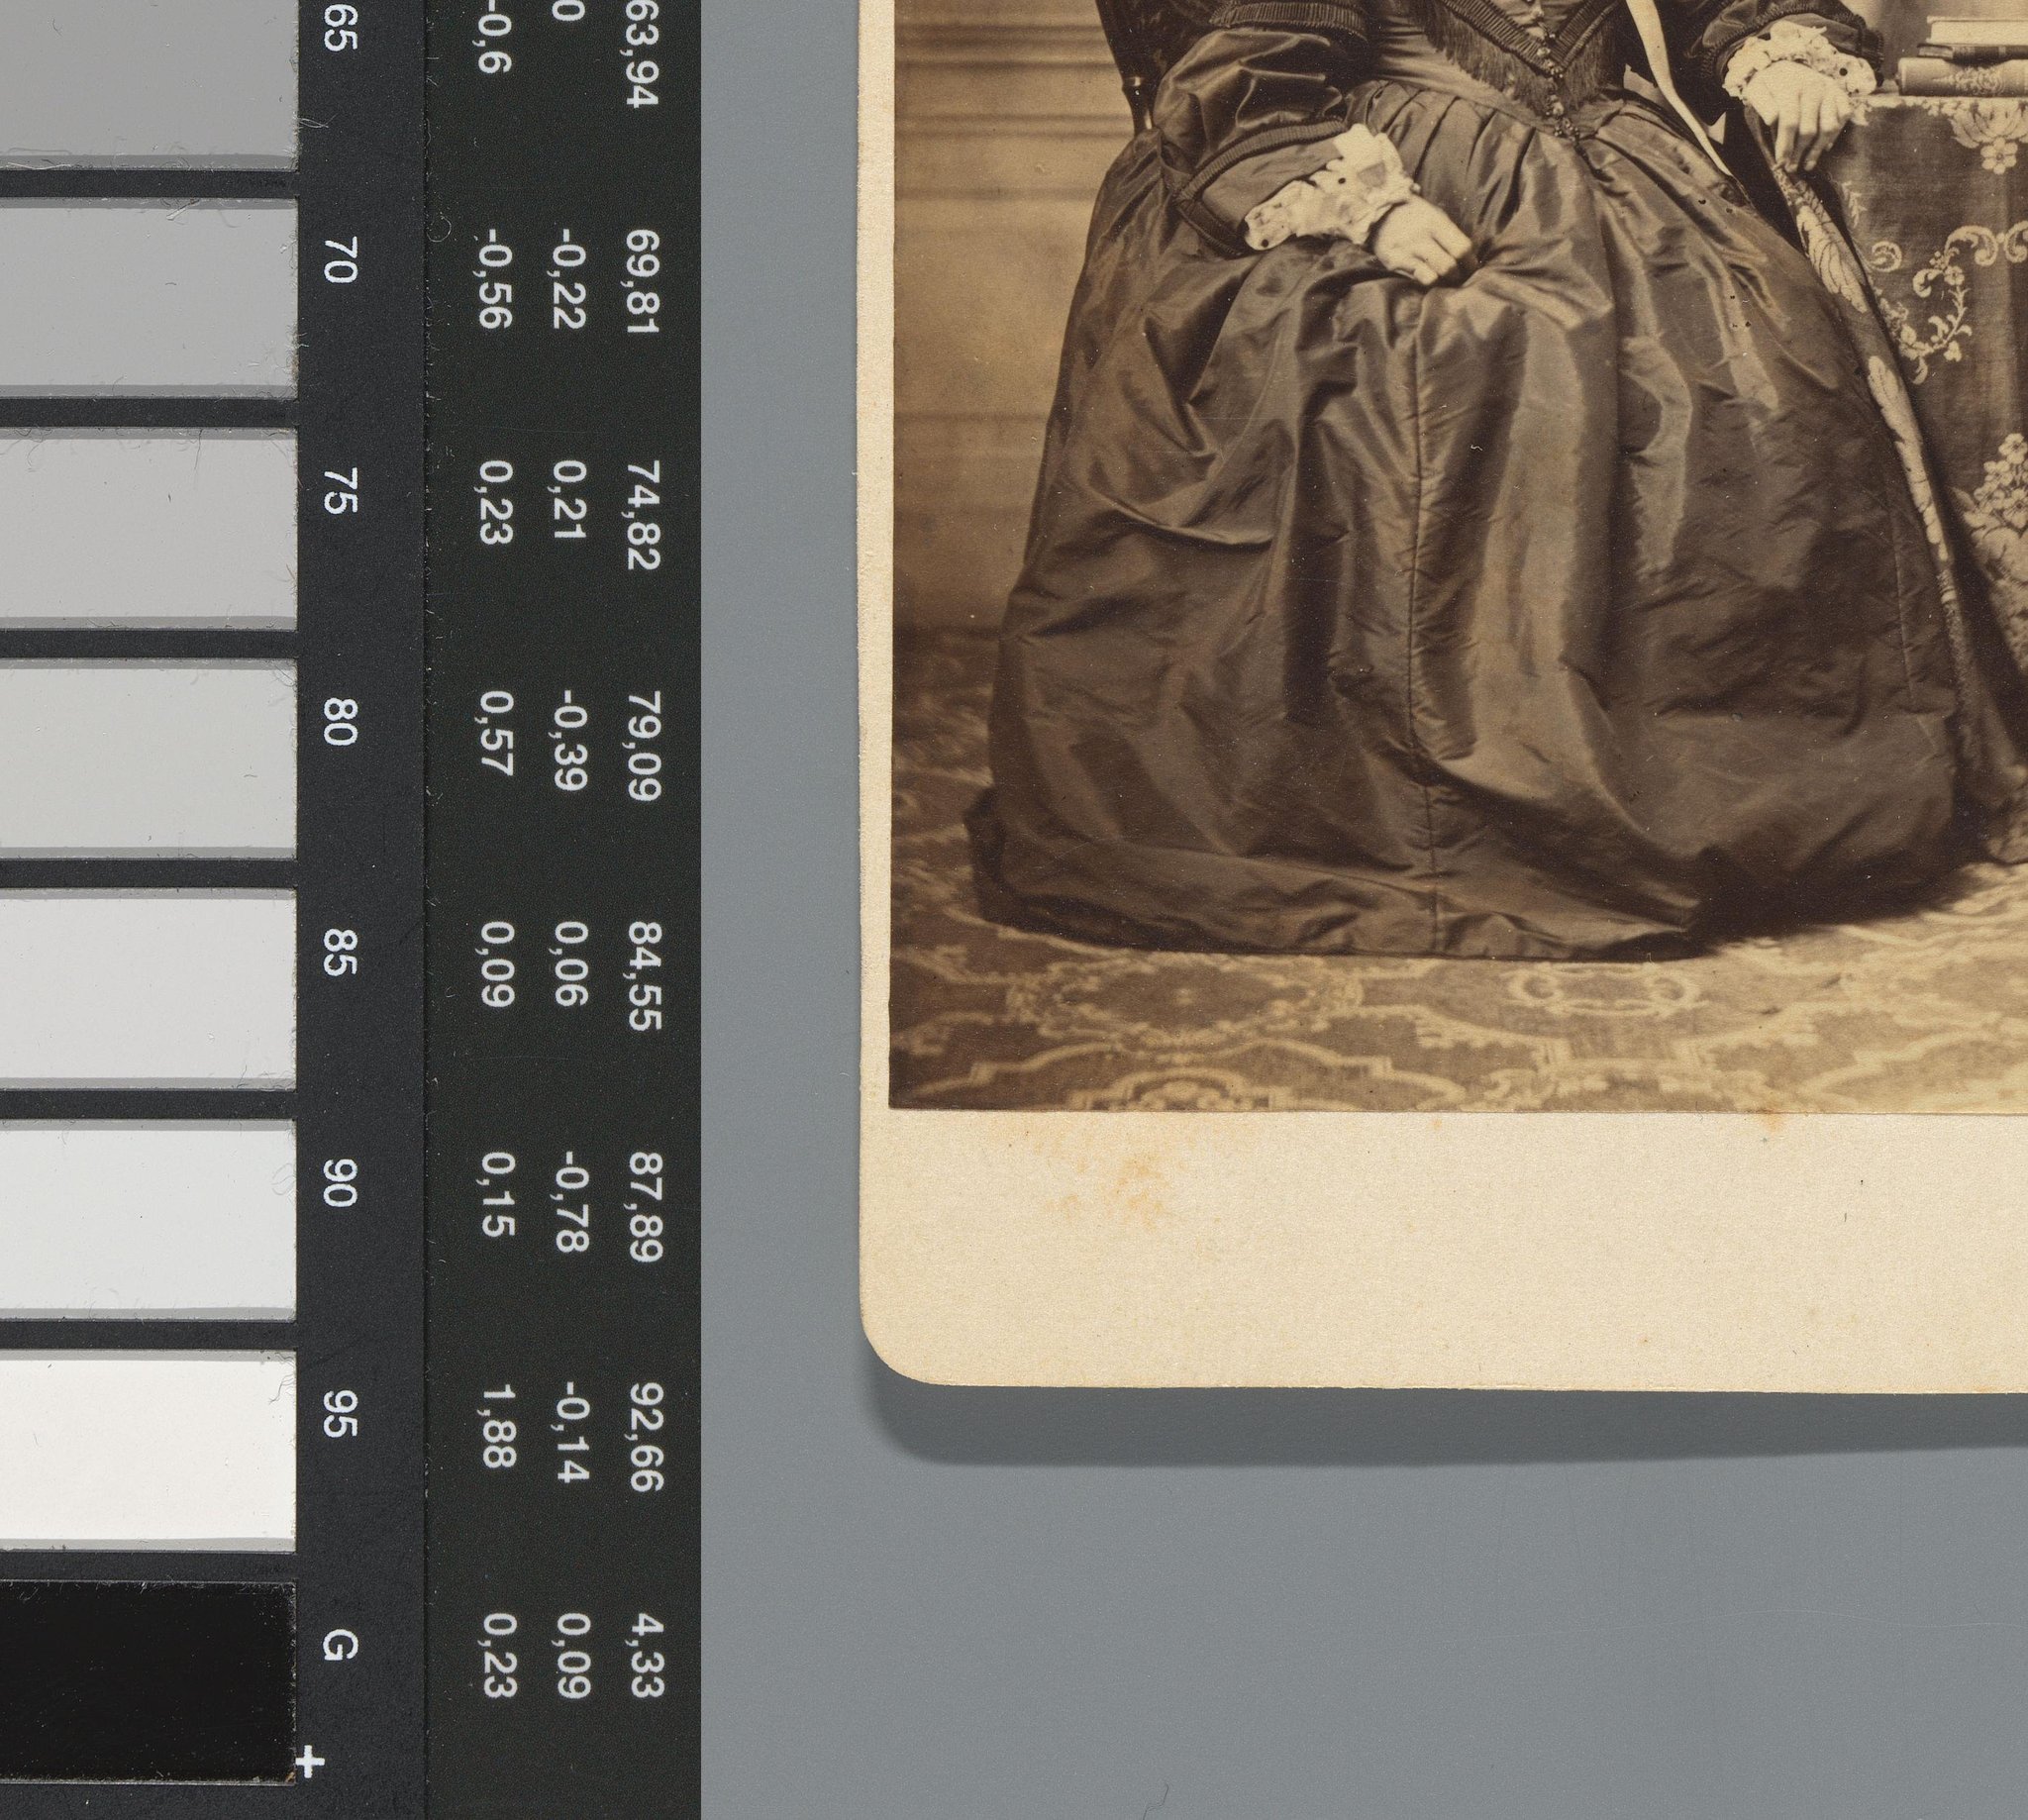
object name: photograph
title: Portret van Johanna Helena Van Kerckhoff-Driebeek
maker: bernardus theodorus van loo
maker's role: print maker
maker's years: 1816-1892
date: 1855-1892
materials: cardboard, photographic support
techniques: albumen print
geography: rotterdam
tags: johanna helena van kerckhoff-driebeek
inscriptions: name: ‘B.T. VAN LOO / ROTTERDAM / Weenaplein’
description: Zittende vrouw met een arm rustend op tafel.